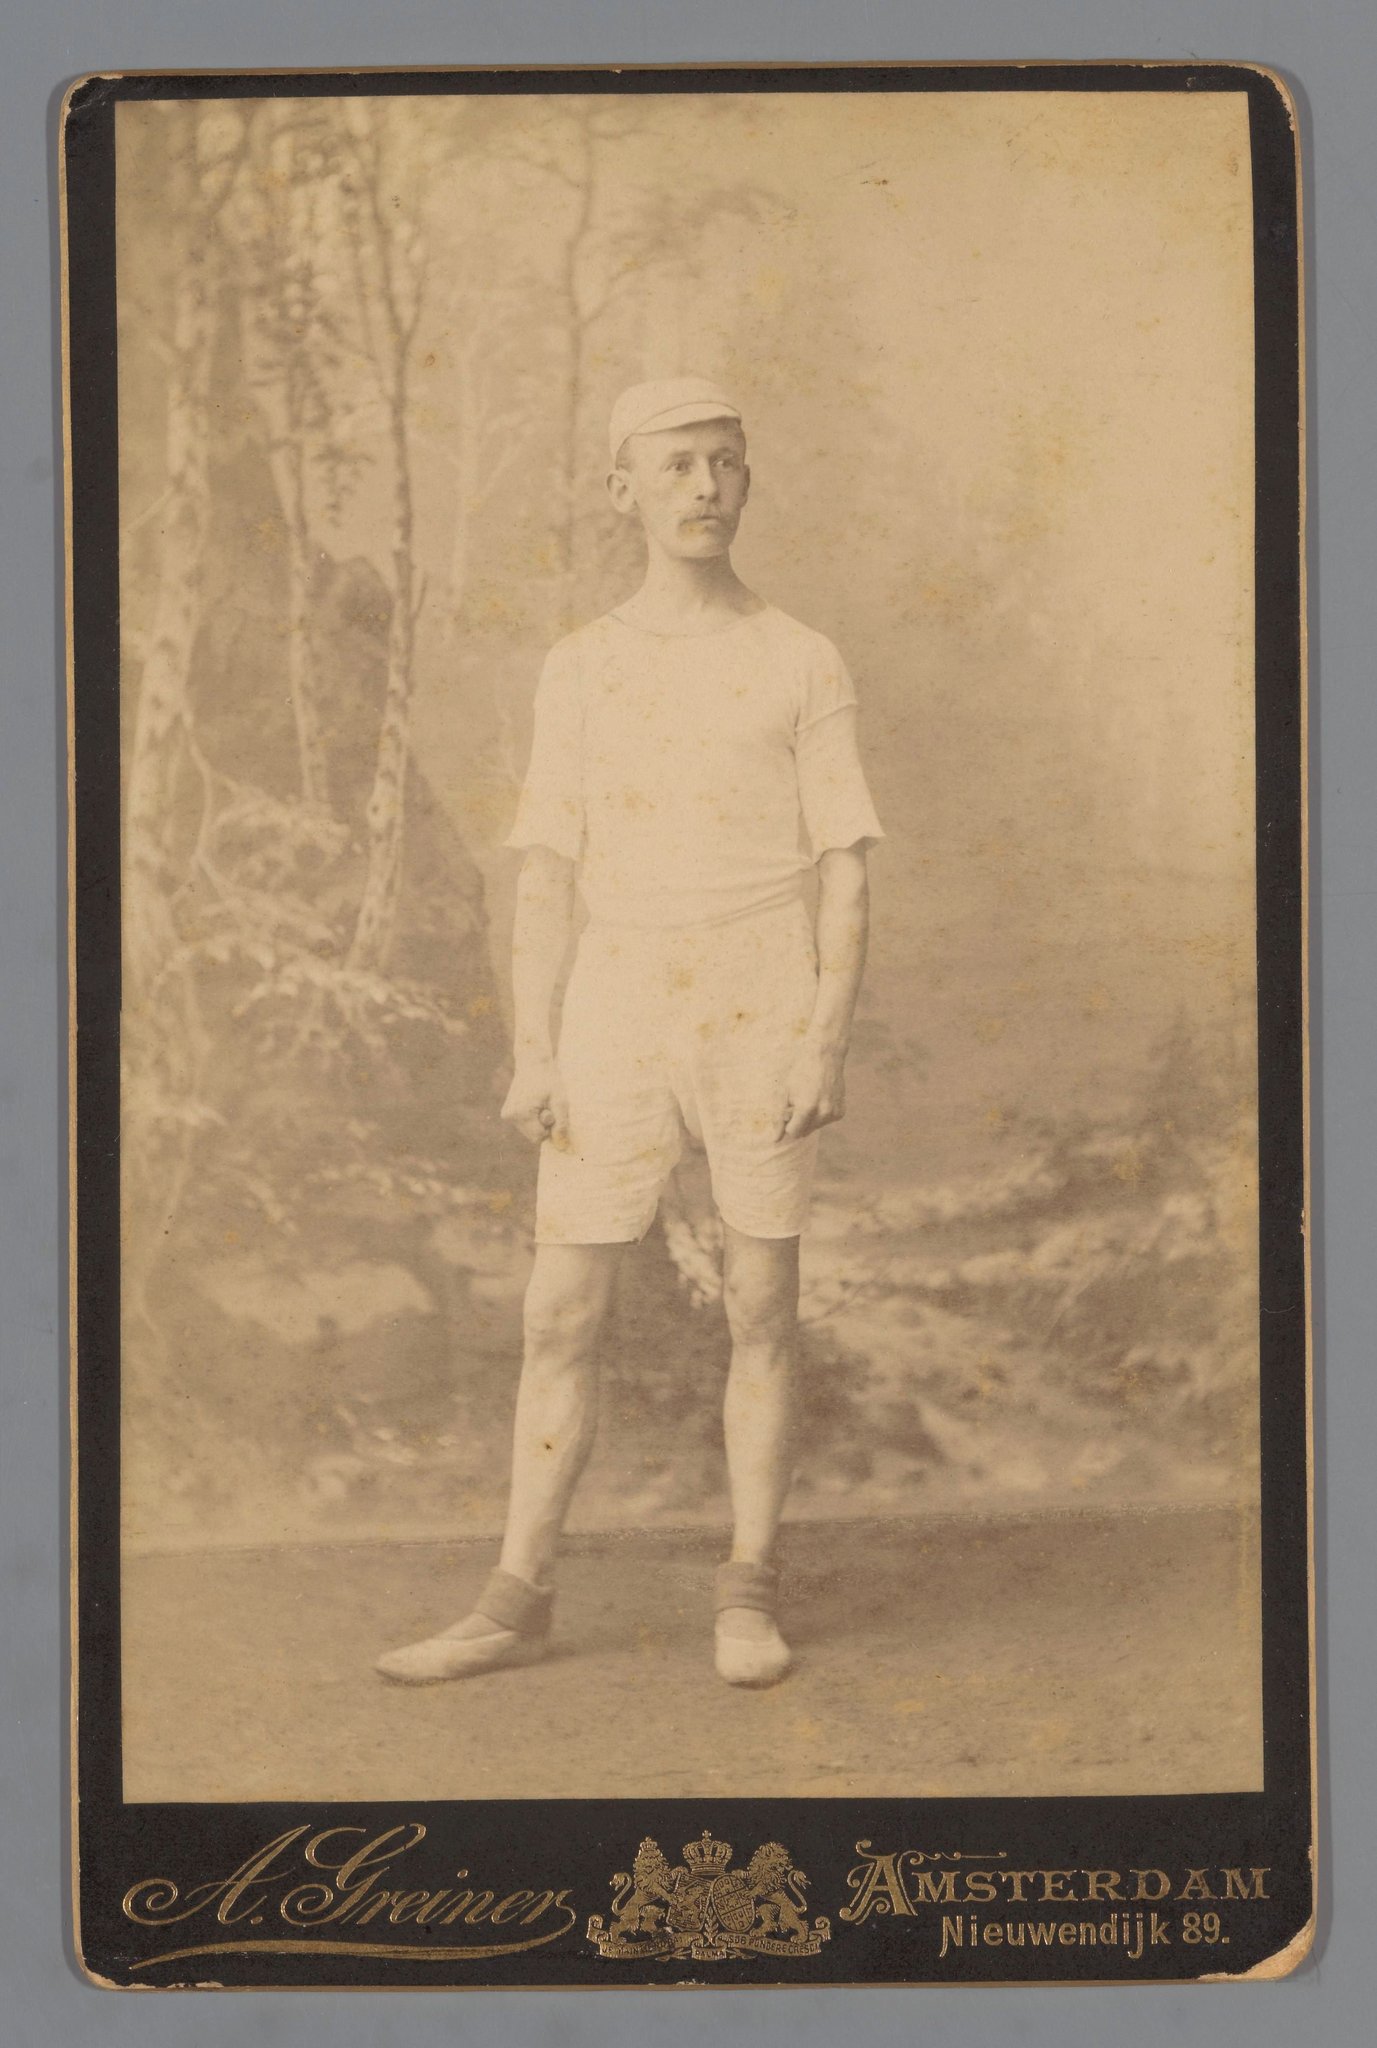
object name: photograph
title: Studioportret van een onbekende man (vermoedelijk) in sportkleding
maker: albert greiner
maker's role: fotograaf, fotostudio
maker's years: 1833-1890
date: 1865-1885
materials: cardboard, photographic support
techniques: albumen print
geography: amsterdam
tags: adult man, clothes, costume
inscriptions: inscription: ‘A. Greiner Amsterdam Nieuwendijk 89.’, inscription: ‘Albert Greiner kon. Ned. Hof-photograaf Amsterdam Nieuwendijk 89. Specialiteit in Vergrootingen’